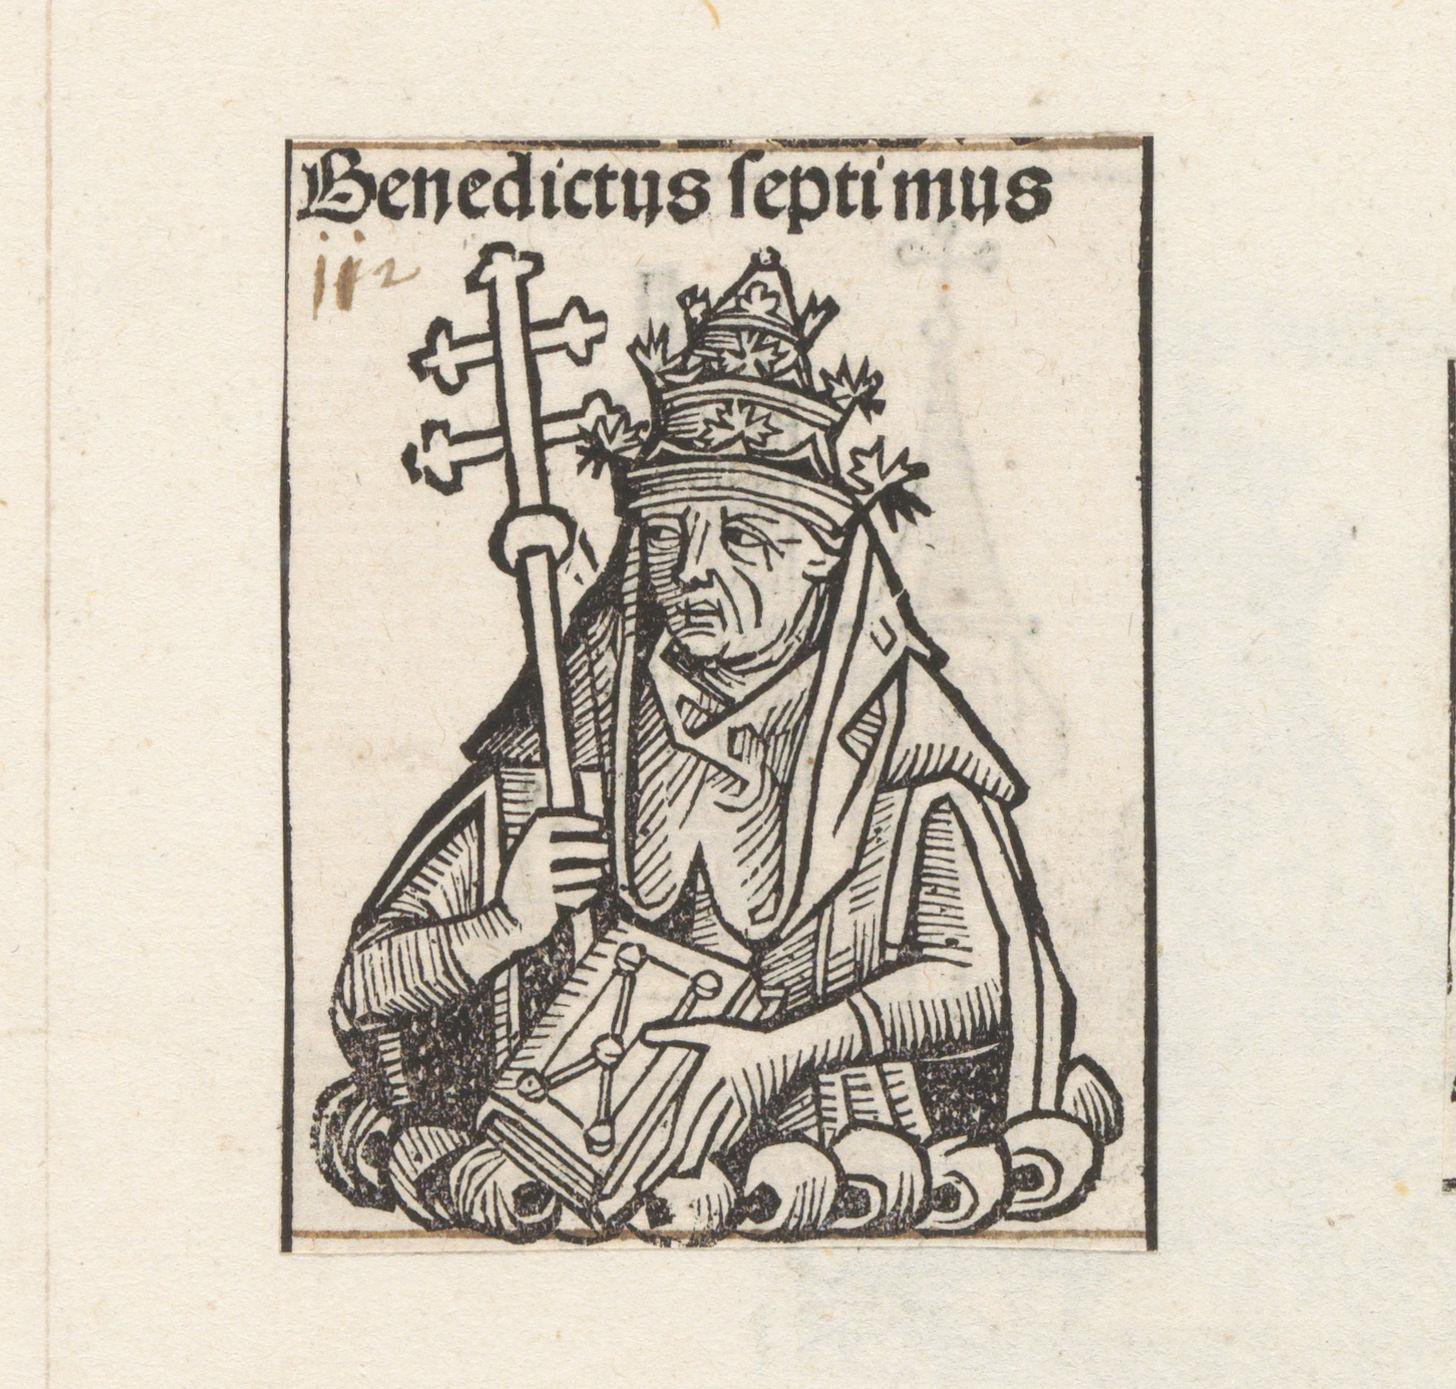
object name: book illustration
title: Benedictus septimus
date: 1493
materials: paper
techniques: letterpress printing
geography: nuremberg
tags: rome, pope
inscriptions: inscription: ‘112’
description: Een bloemkelk met een paus. Hij draagt een tiara en heeft een bijbel en een staf met een dubbel kruis in zijn handen. De voorstelling is onderdeel van de opeenvolging pausen in de Liber Chronicarum. De tekst identificeert de man als Benedictus VII. De prent maakt deel uit van een album.